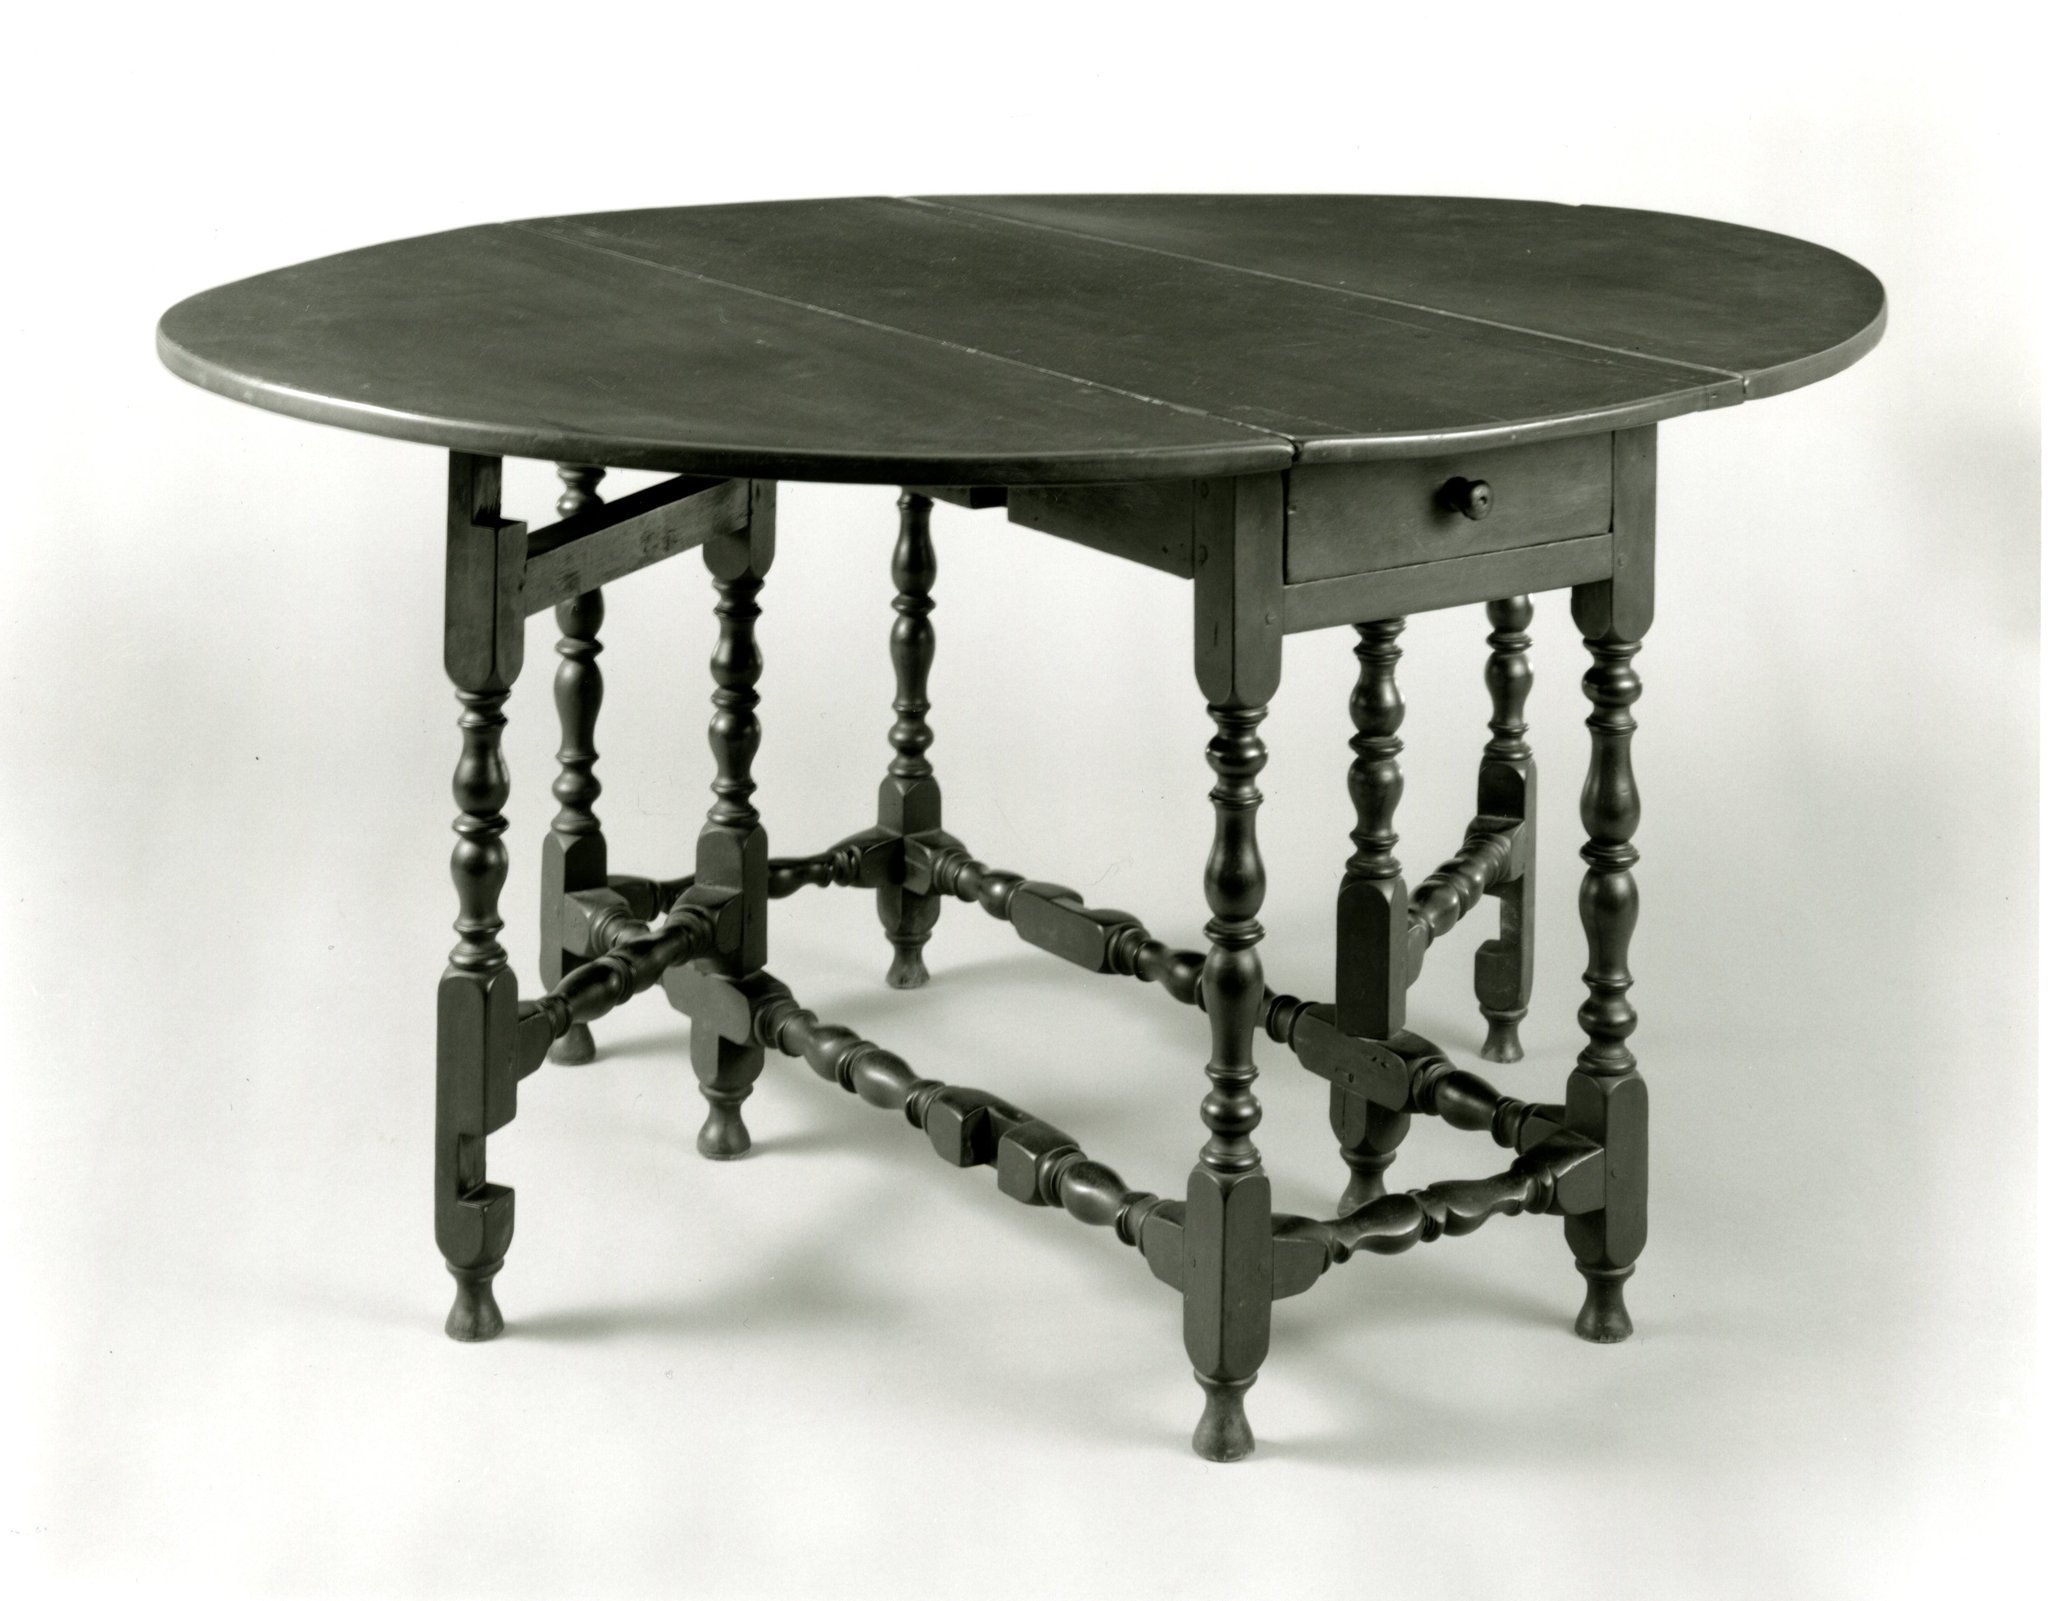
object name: drop leaf table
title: Drop-leaf Table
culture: american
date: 1700-1730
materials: wood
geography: united states